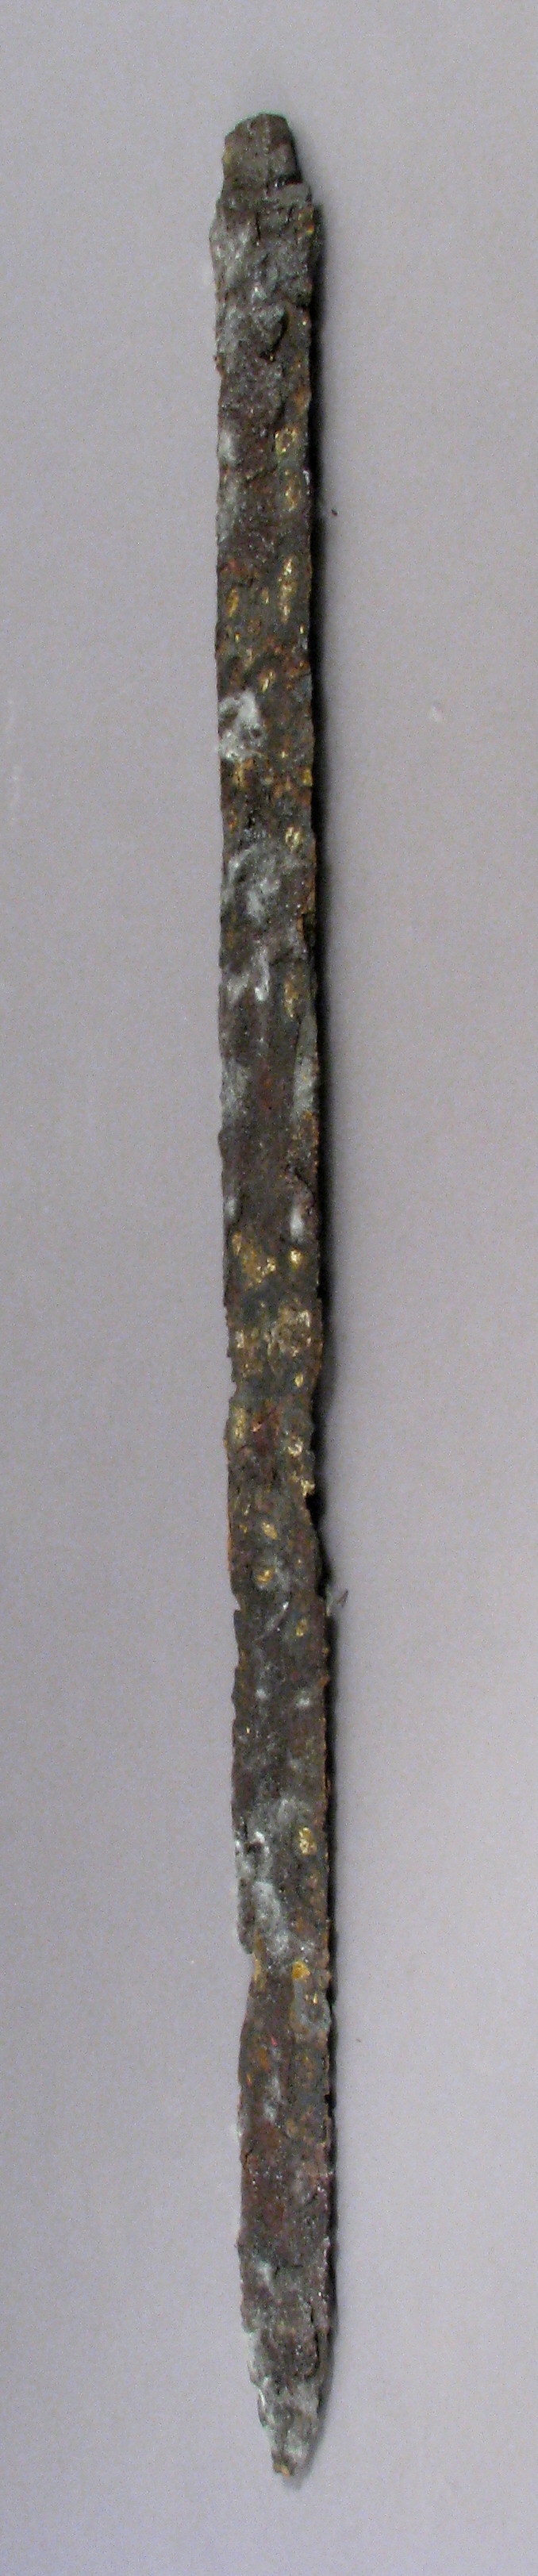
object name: sword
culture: frankish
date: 500-700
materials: iron